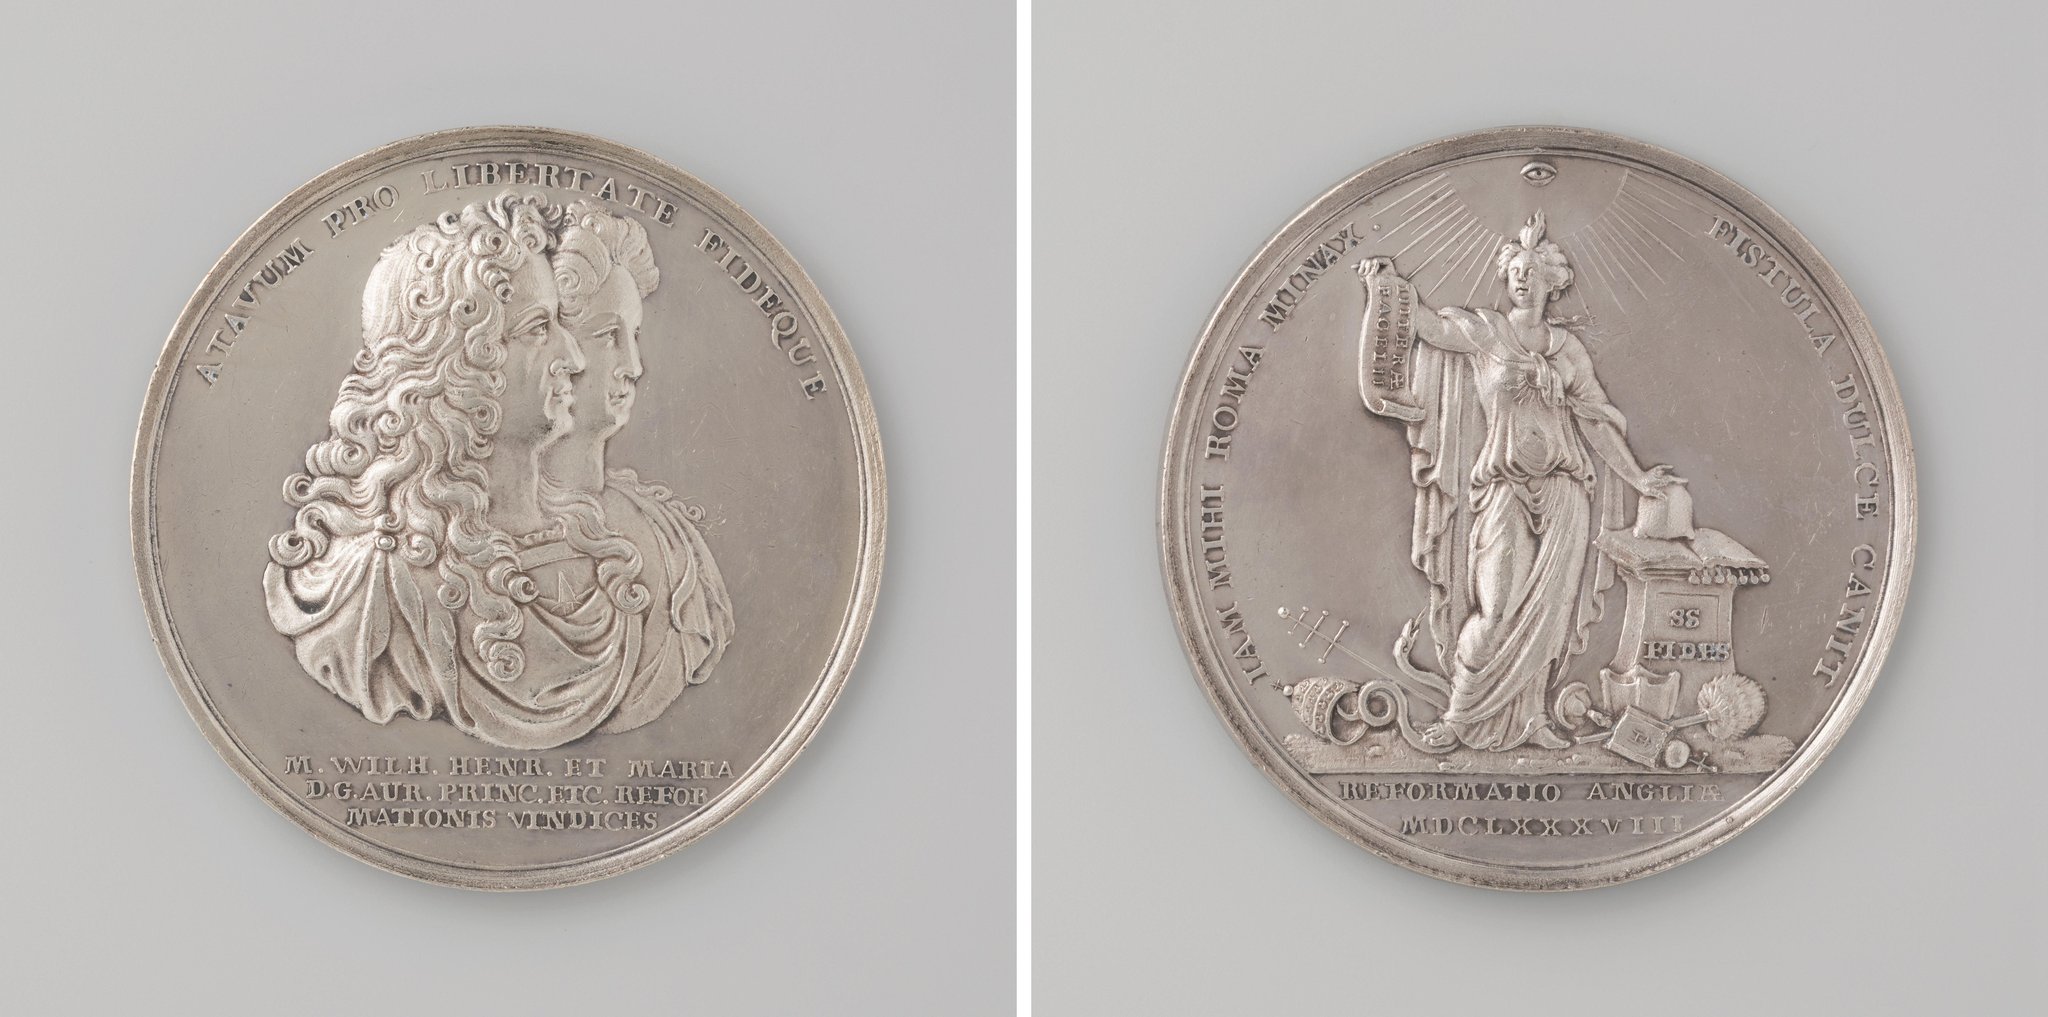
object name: history medal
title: Willem III uitgenodigd om de protestanten in Engeland te verdedigen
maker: Anonymous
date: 1688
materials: silver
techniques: striking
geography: netherlands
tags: the hague, william iii (prince of orange and king of england, scotland, and ireland), maria ii stuart (koningin van engeland, schotland en ierland), england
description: Zilveren penning. Voorzijde: borststuk man en vrouw boven opschrift binnen omschrift. Keerzijde: Engelse Protestantisme beschenen door stralend alziend oog, houdt in ene hand brief en steunt met andere hand op hoed en open bijbel op altaar, terwijl zij symbolen van katholicisme vertrapt binnen omschrift; afsnede: opschrift.